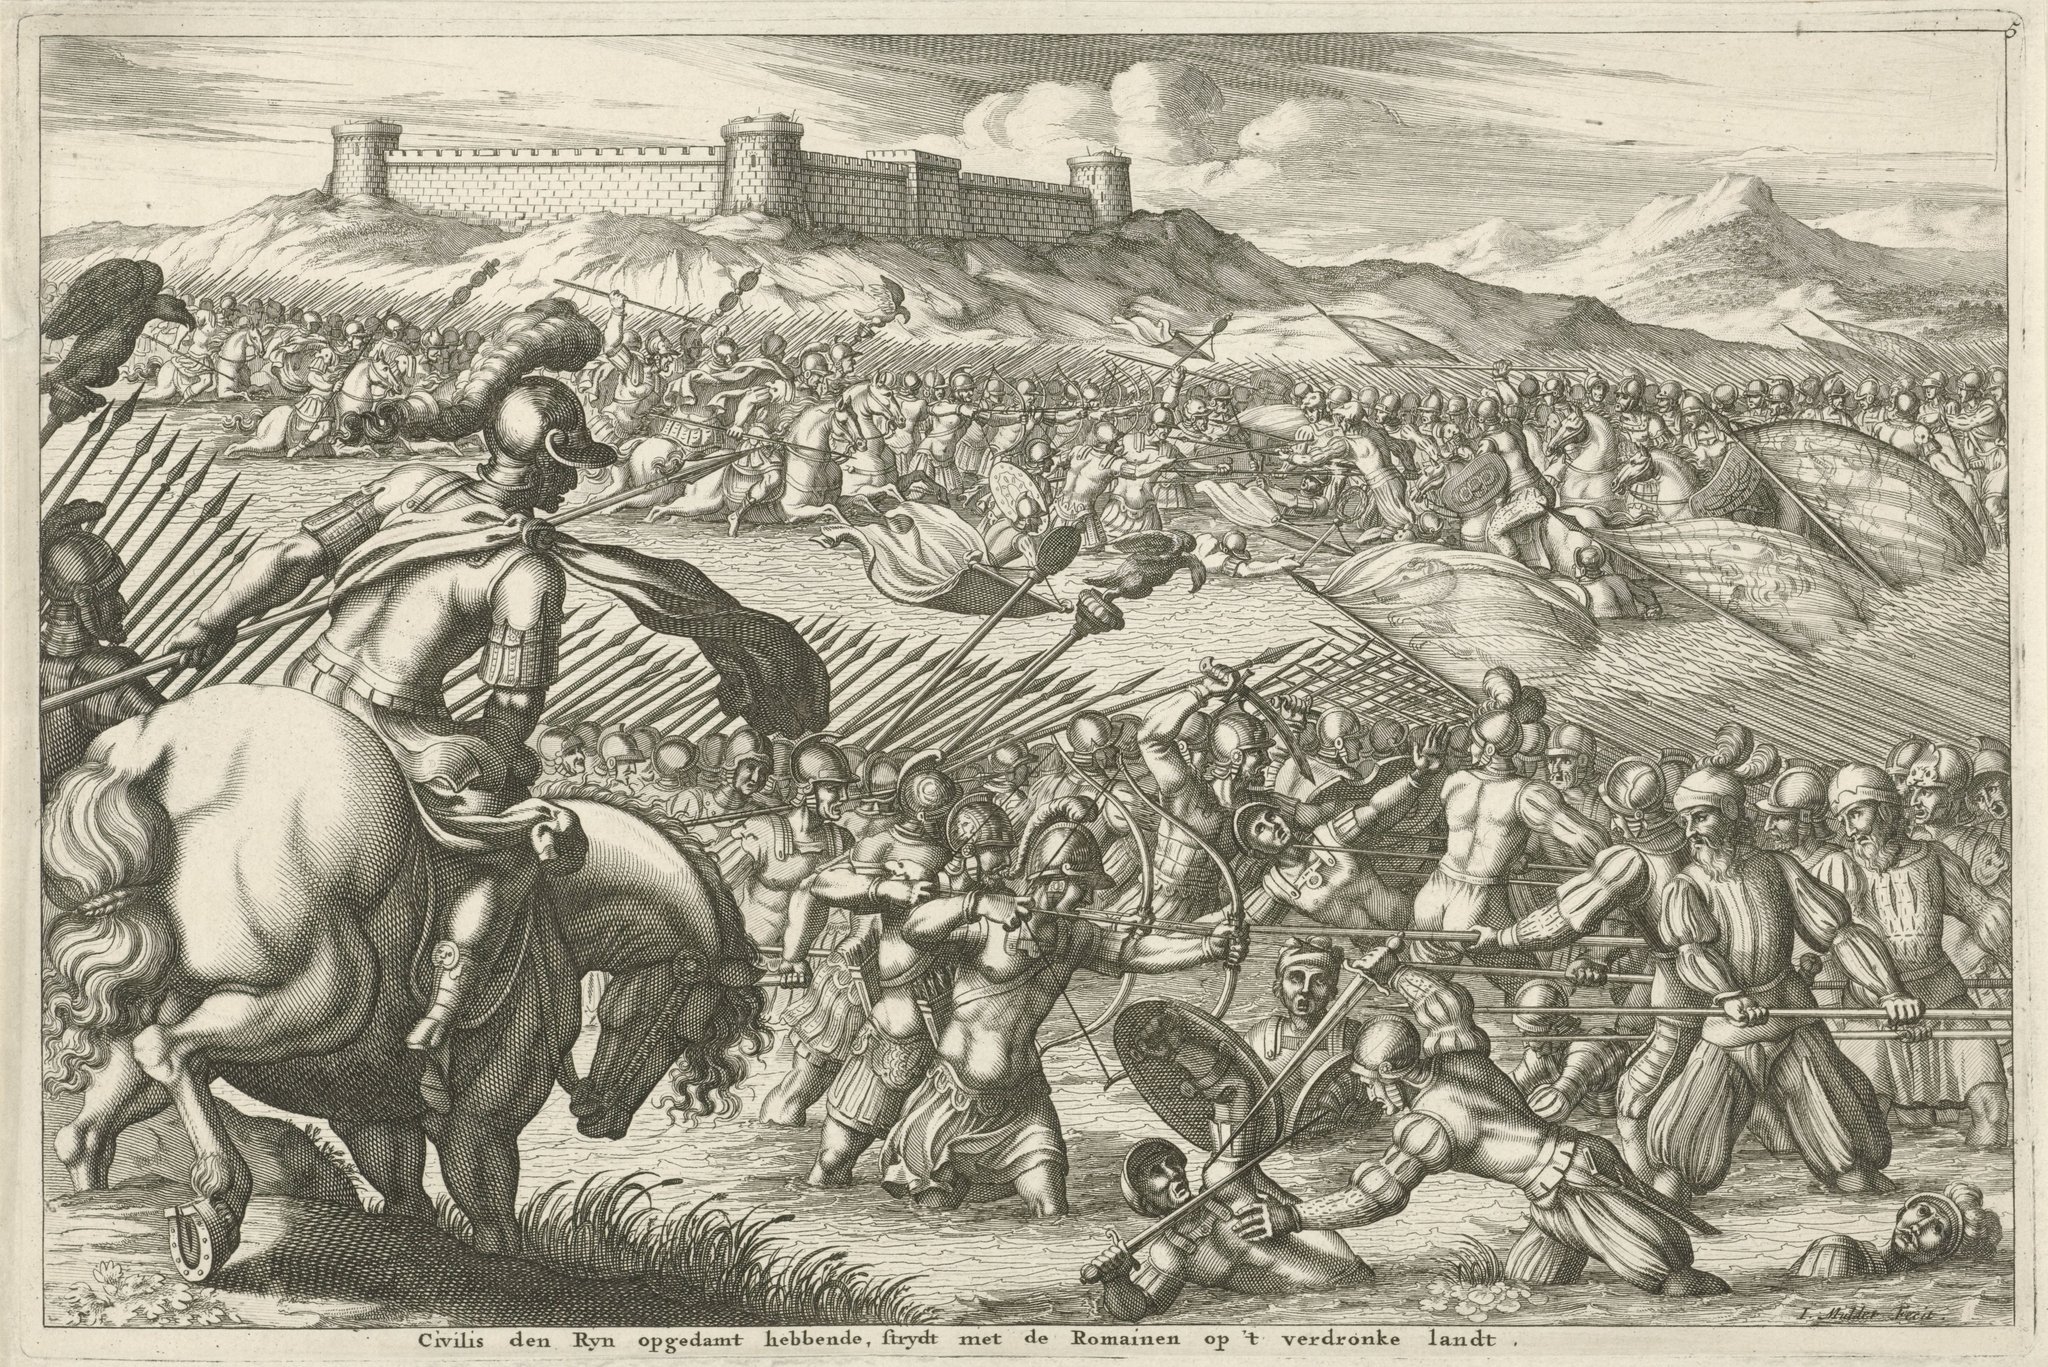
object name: book illustration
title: Civilis den Ryn opgedamt hebbende, strydt met de Romainen op 't verdronke landt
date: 1684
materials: paper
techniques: engraving, etching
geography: amsterdam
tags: dike-break, battle, fighting in general, (story of) julius claudius civilis, extinct, 'historical' peoples (with name), netherlands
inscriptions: collector's mark: Lugt 2228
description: Prent uit: Tacitus, Cornelius. Jaarboeken en Historien (...). [Vertaald uit het Latijn door] Pieter Corneliszoon Hooft. Amsterdam: Jacob de Jonge (wed.), Dirk Boom (wed.) en Hendrick Boom, 1684.